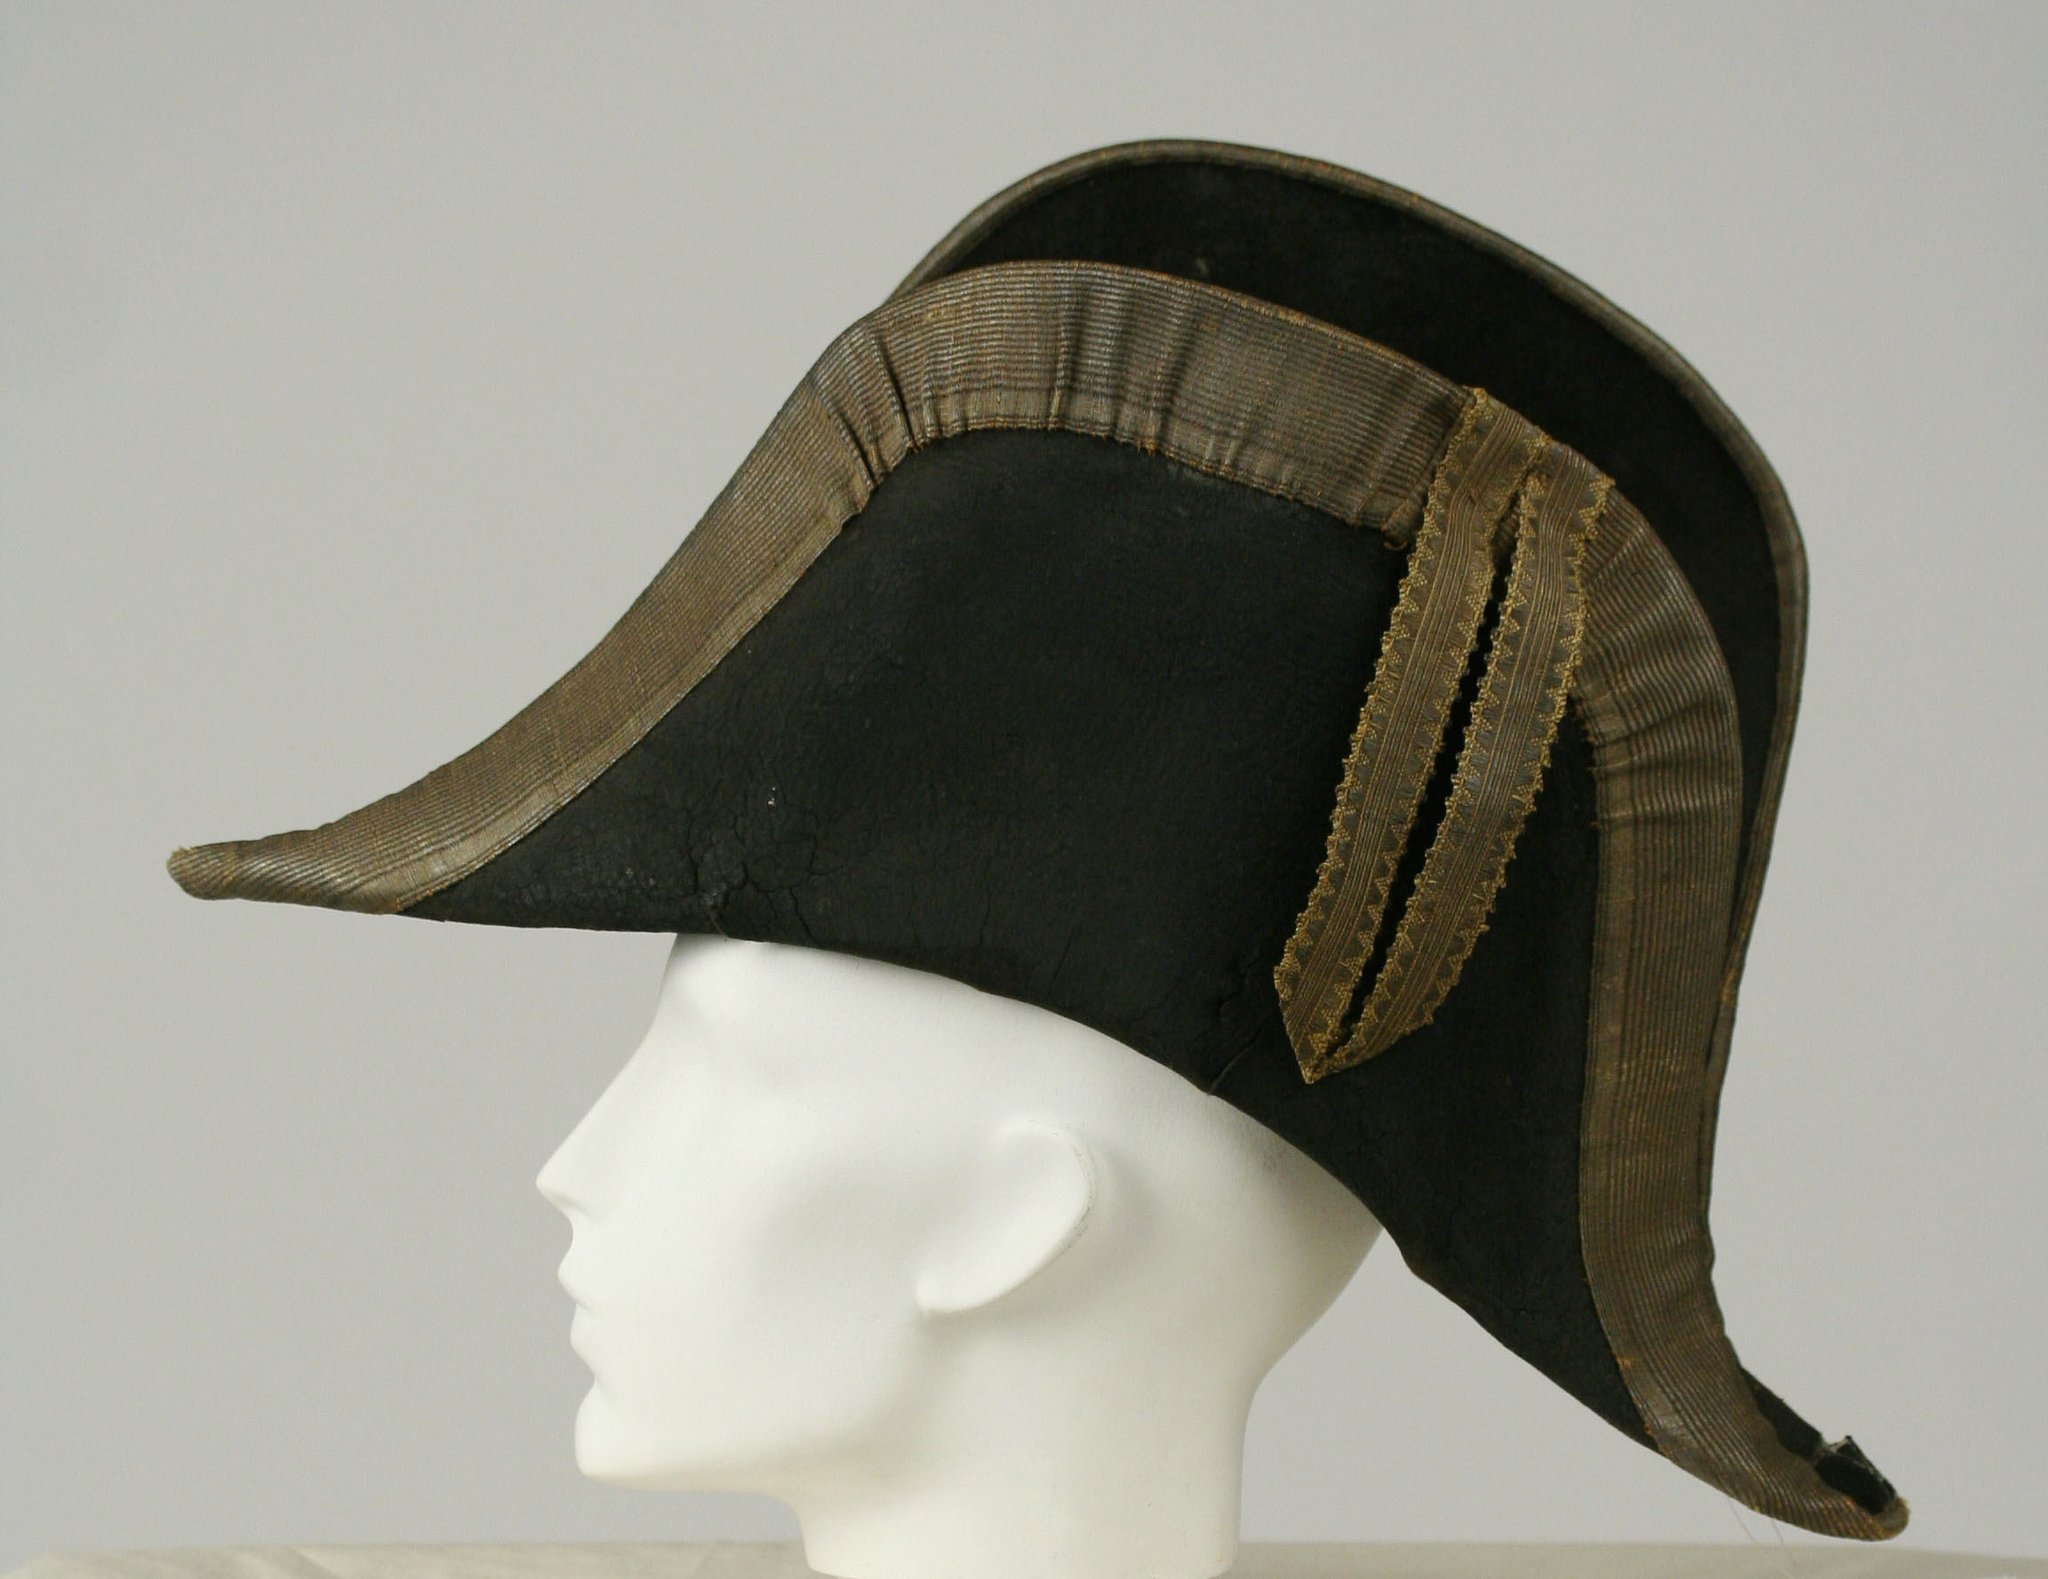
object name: hat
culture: italian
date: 1767-1833